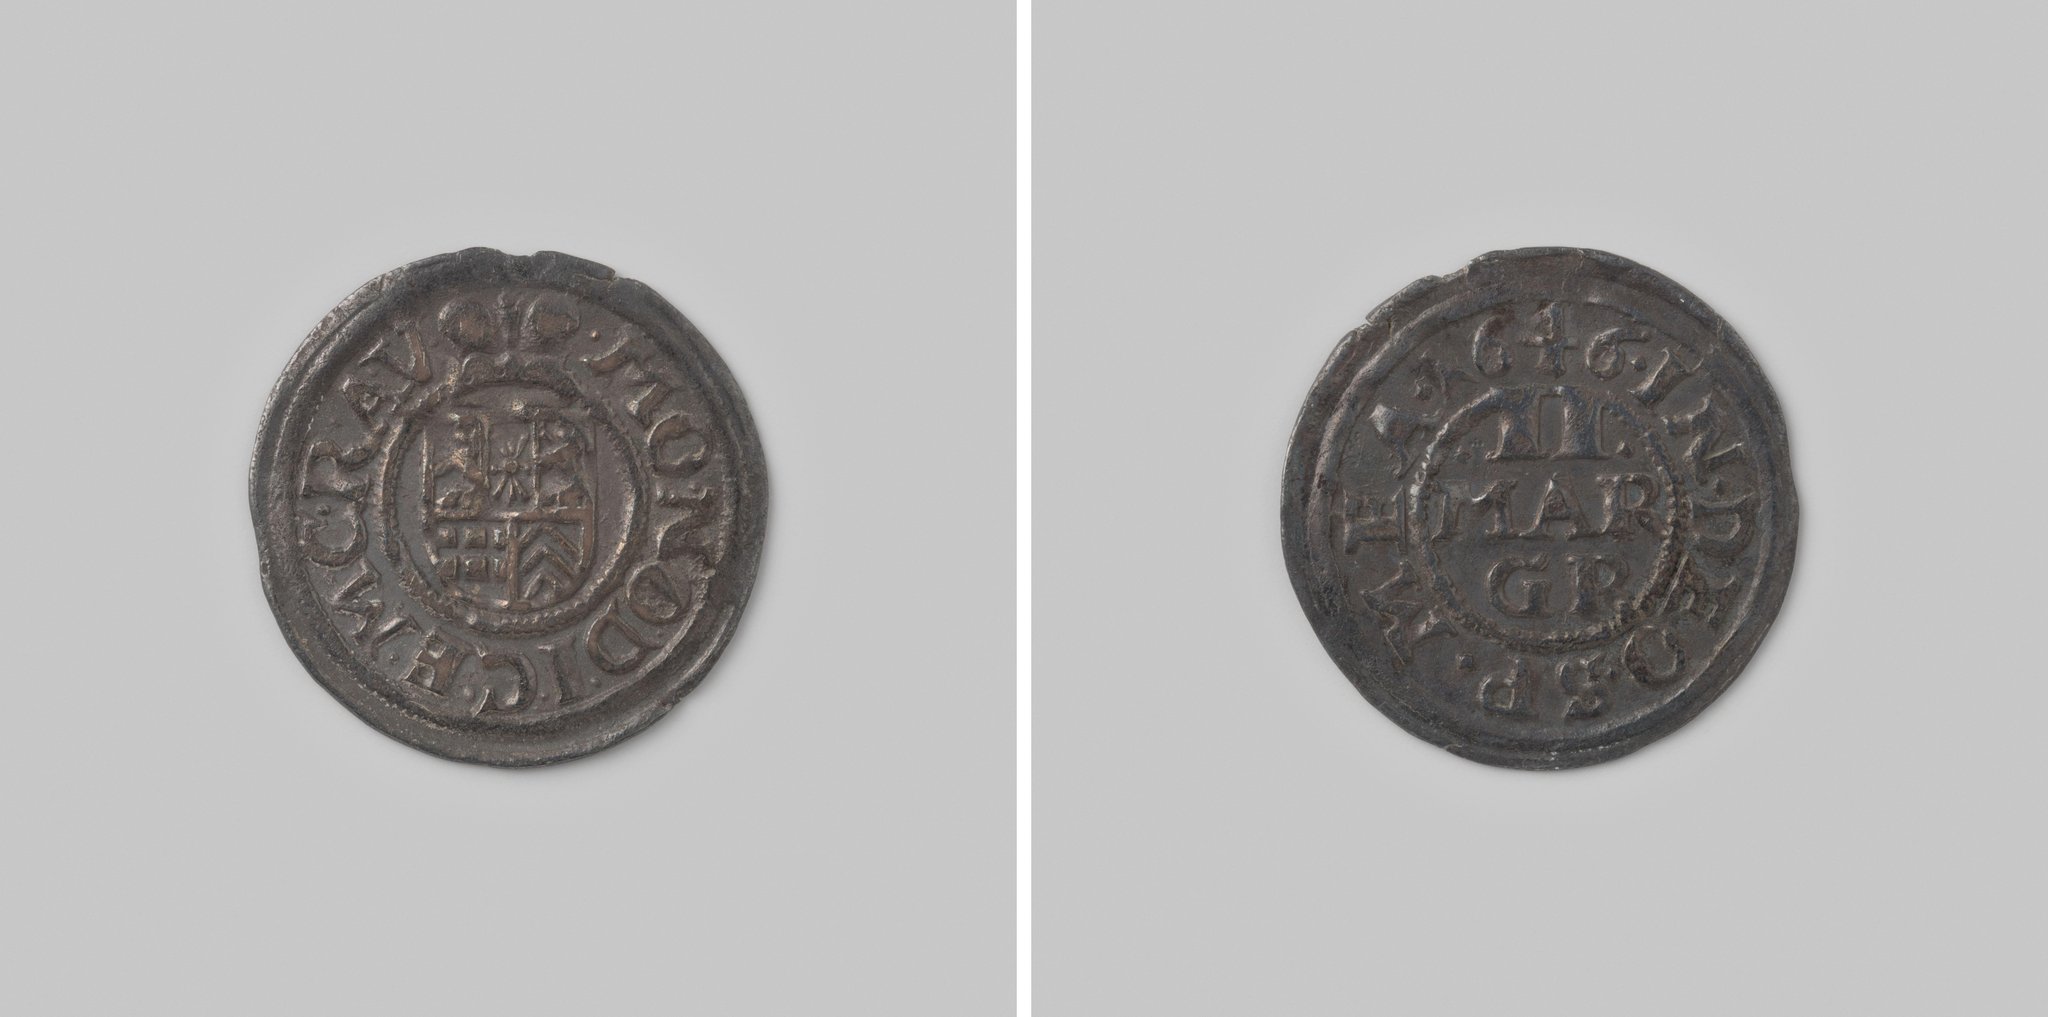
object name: coin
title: Mariengroschen uit het hertogdom Kleef van Albrecht Friedrich en Philip Ludwig, 1646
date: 1646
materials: silver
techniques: striking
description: Zilveren munt. Voorzijde: samengesteld wapenschild. Keerzijde: waarde-aanduiding in drie regels. Jaartal in omschrift bovenaan.